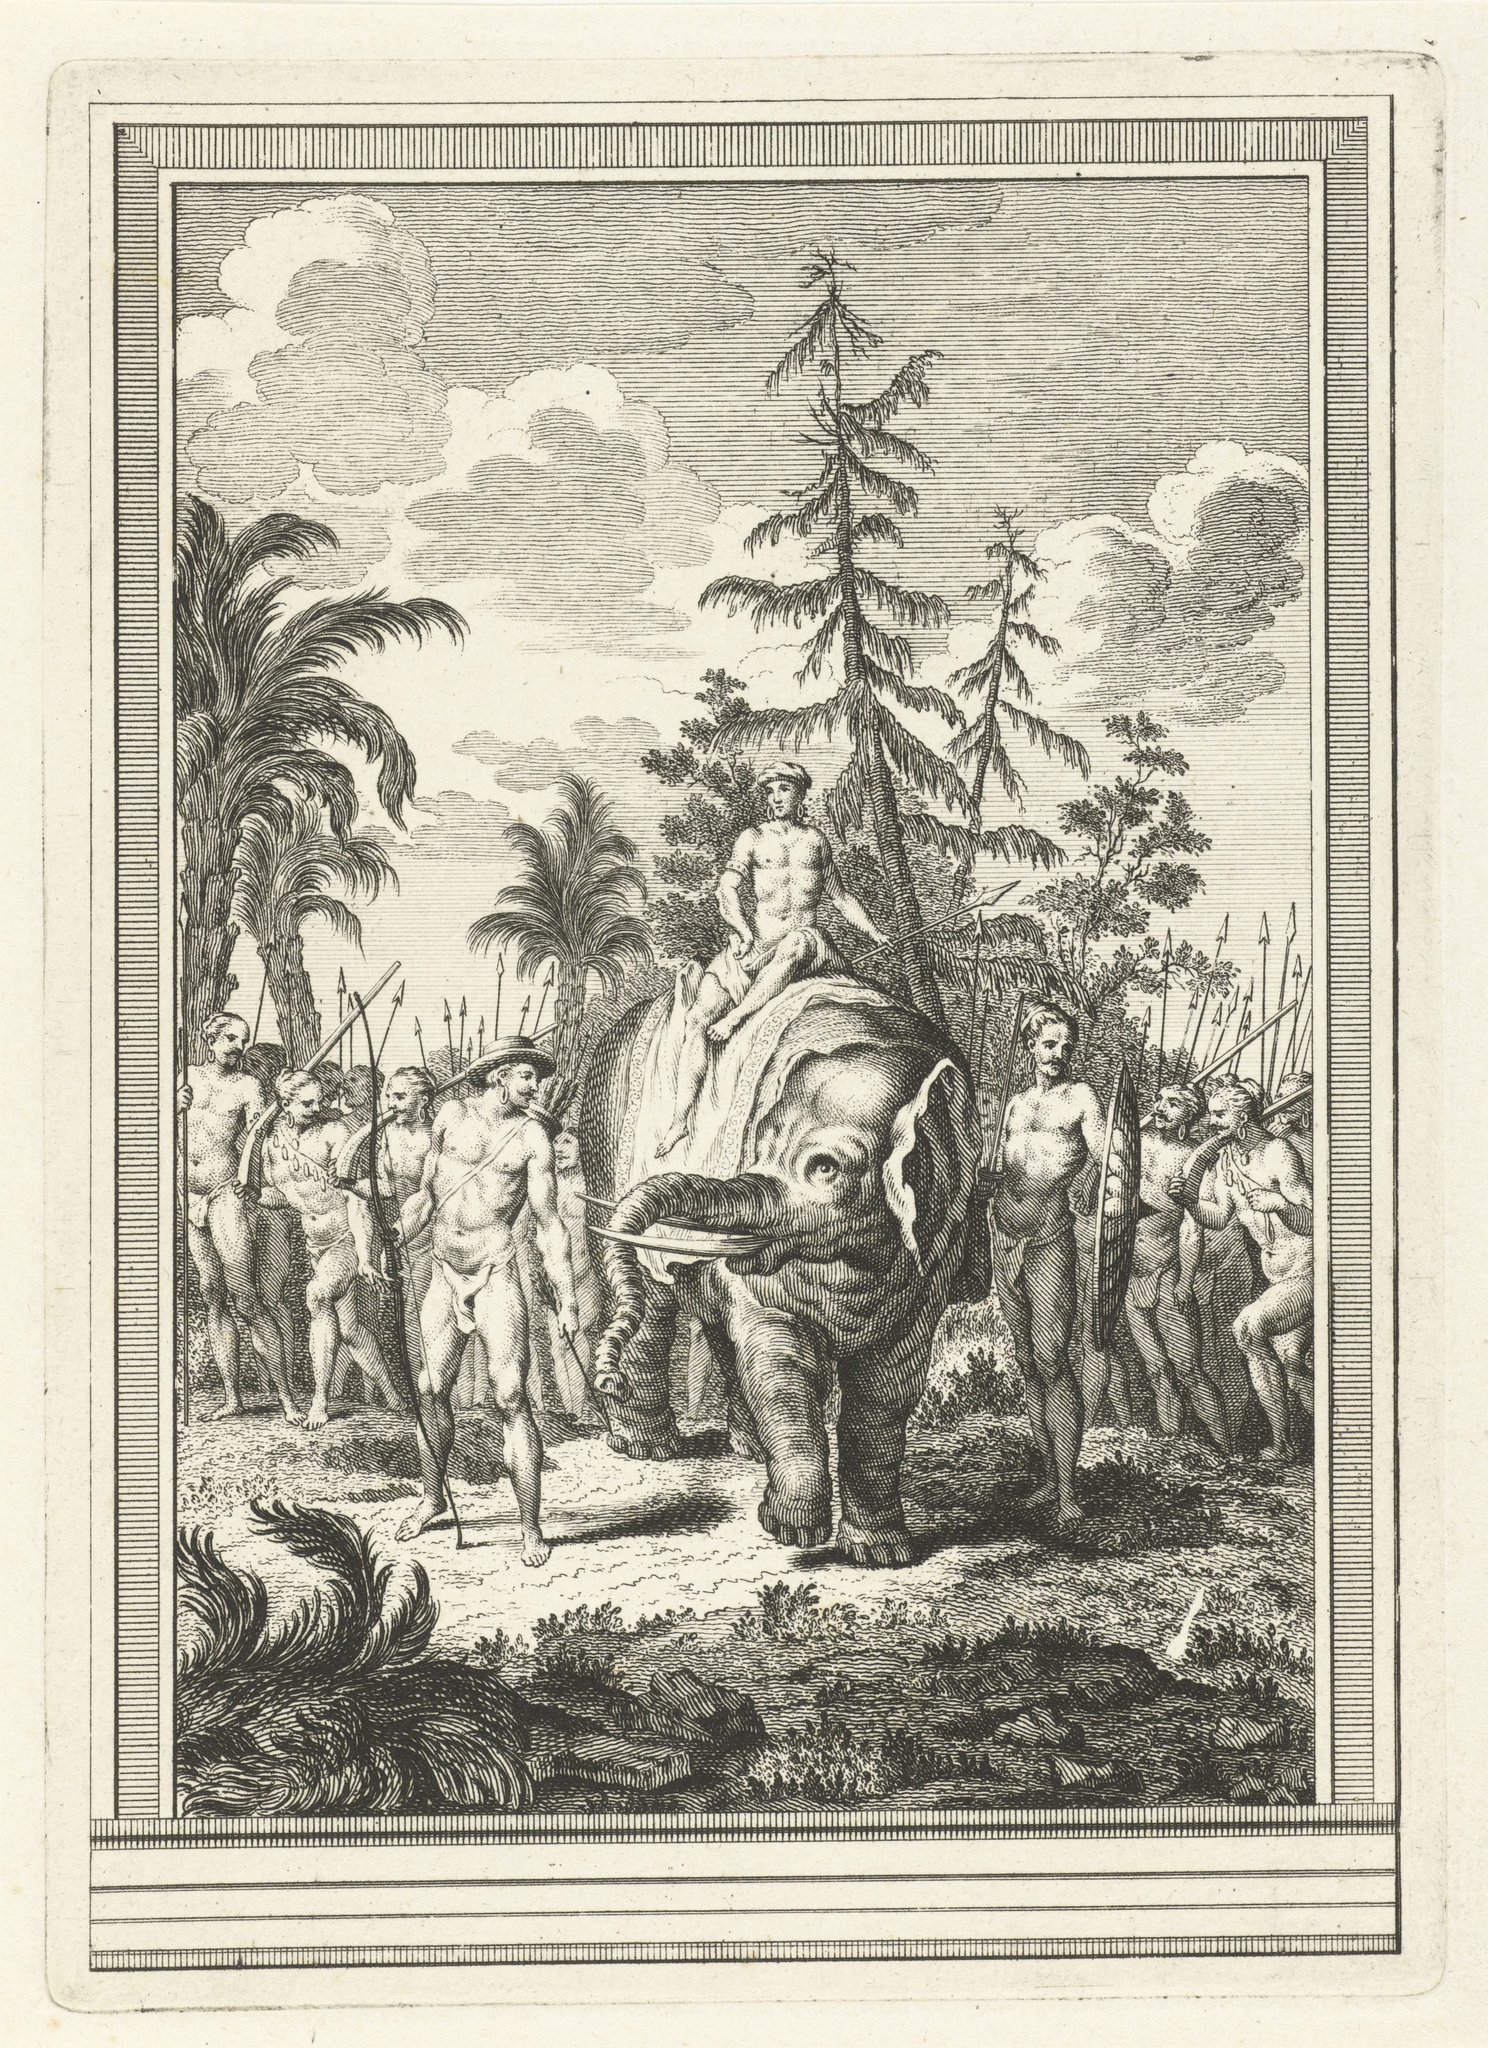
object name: print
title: Mannen met een olifant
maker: jacob van der schley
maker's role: draughtsman, print maker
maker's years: 1715-1779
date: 1749-1779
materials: paper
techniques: engraving, etching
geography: amsterdam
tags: trunked animals: elephant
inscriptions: collector's mark: Lugt 240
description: Een groep mannen met oorringen, snorren en speren en een olifant in een tropisch landschap. Een van de mannen zit op het dier.